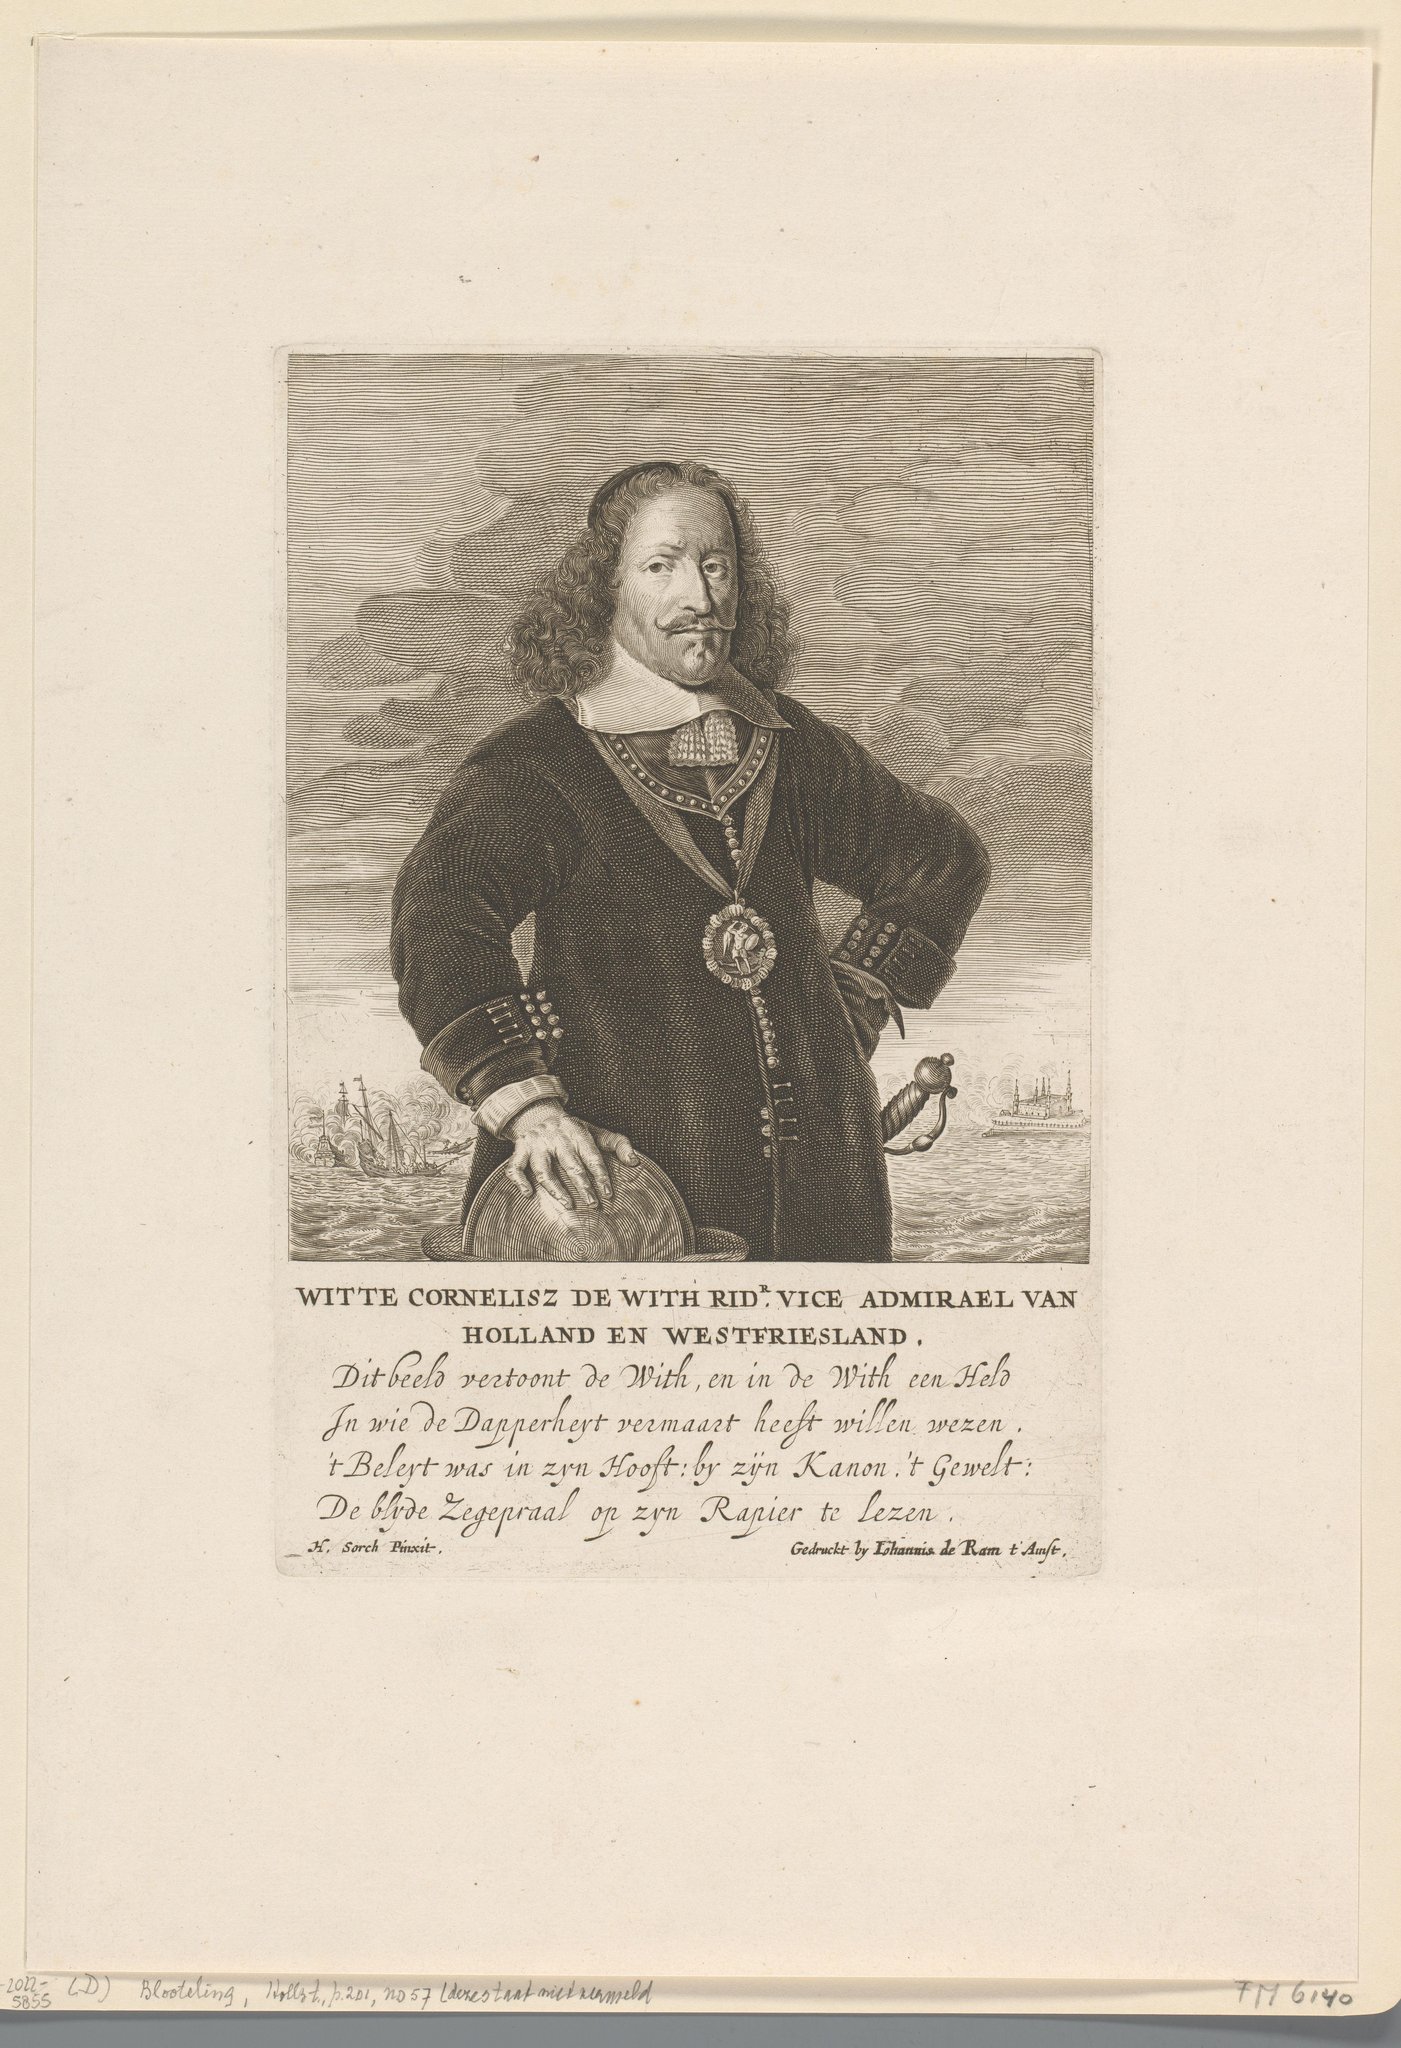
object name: print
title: Portret van Witte Cornelisz. de With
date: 1668-1693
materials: paper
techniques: engraving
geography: amsterdam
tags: sailing-ship, sailing-boat, historical persons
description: Met vierregelig lofdicht in het Nederlands.